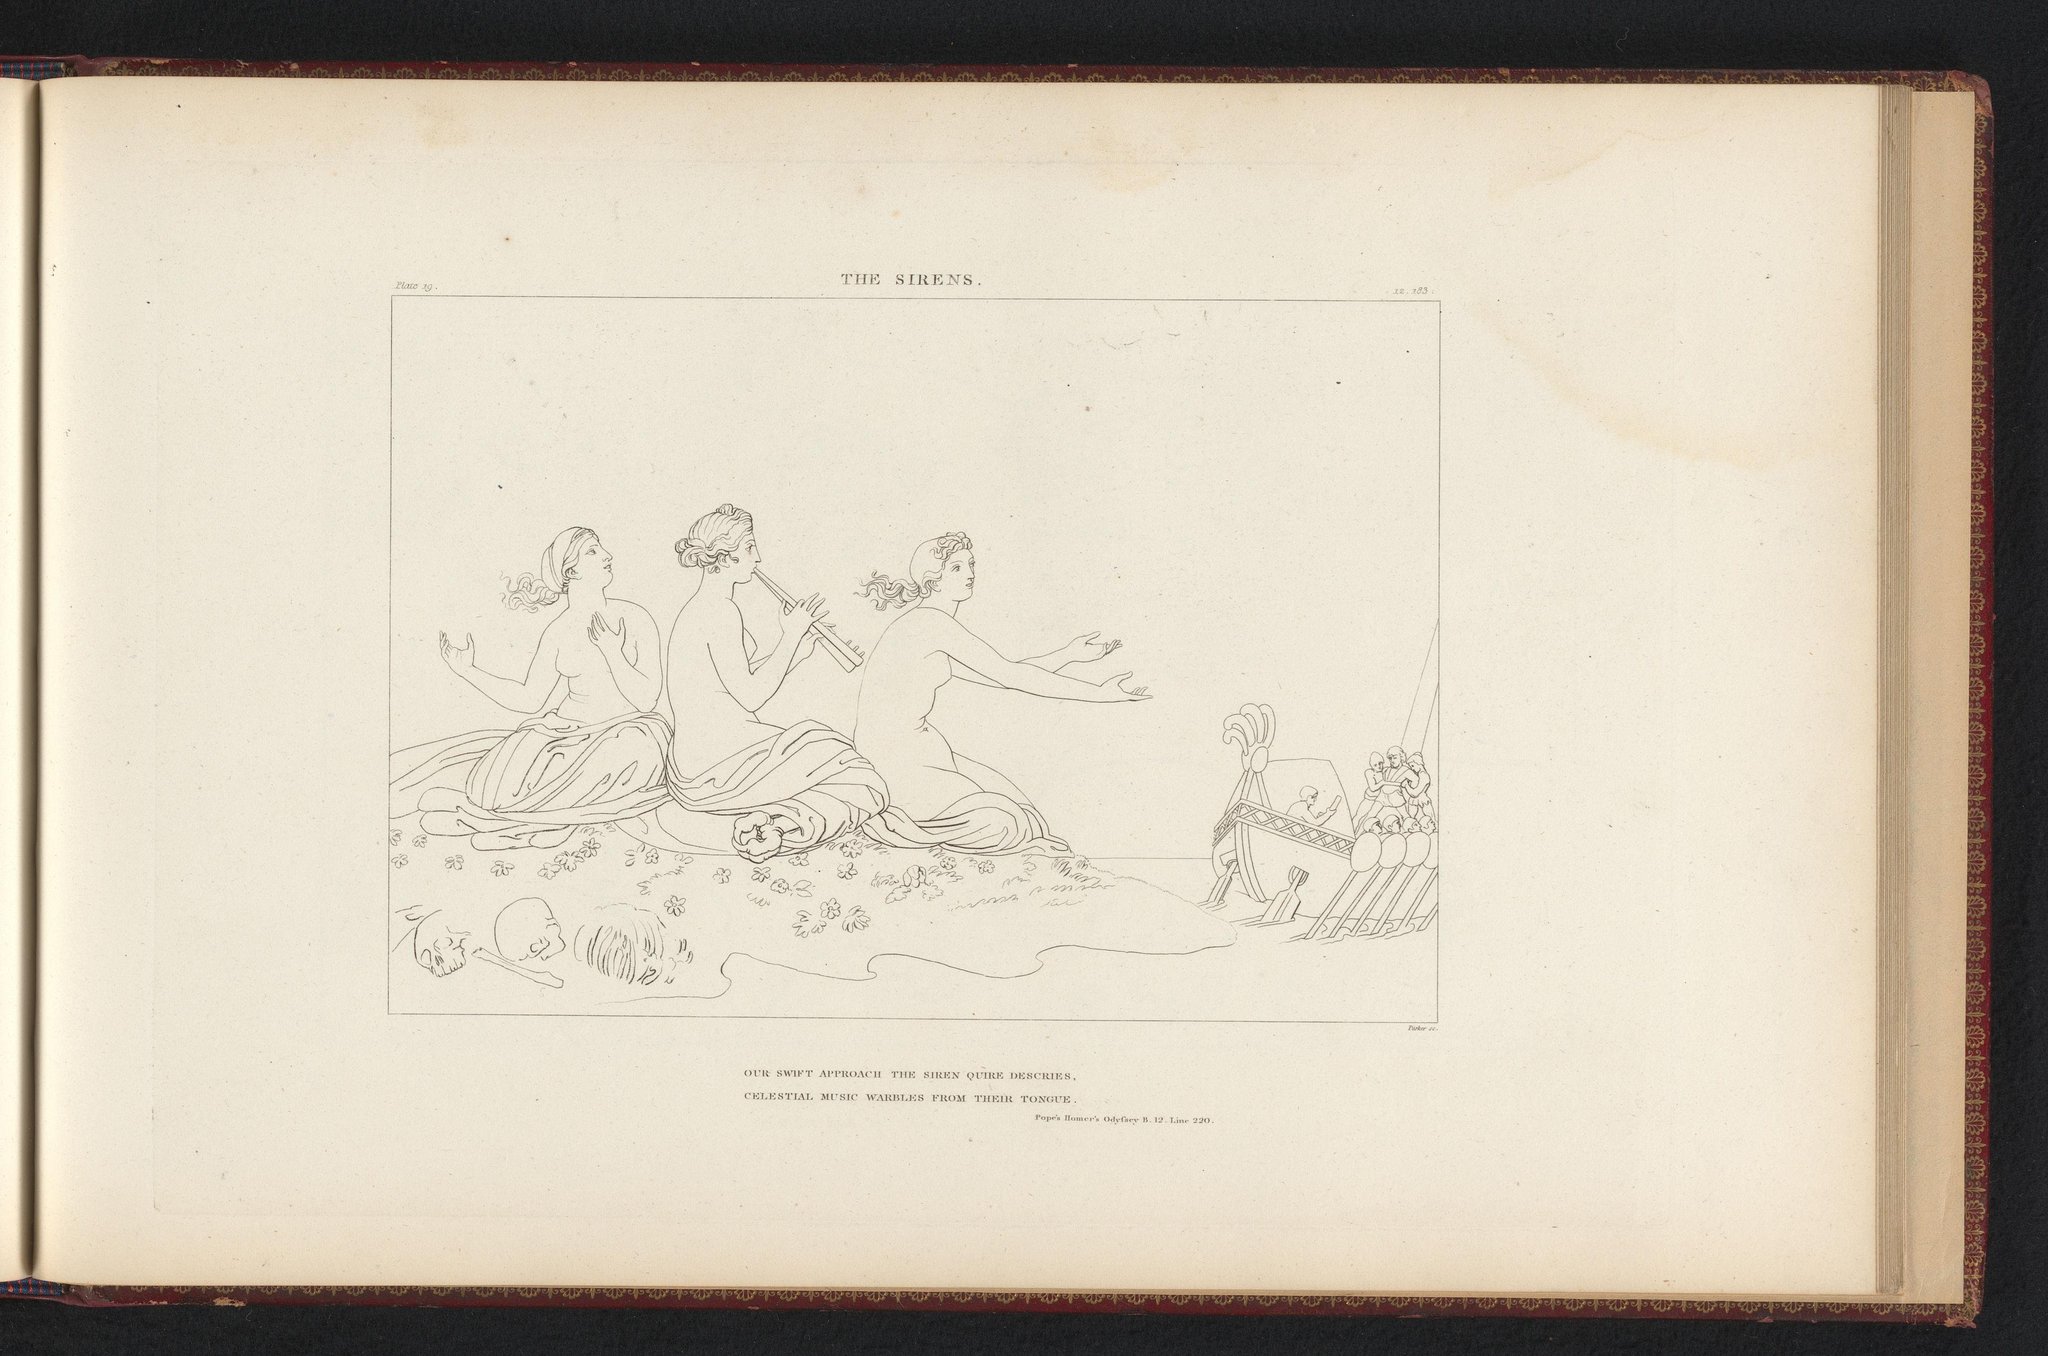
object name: print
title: The Sirens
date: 1805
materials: paper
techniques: etching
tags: ulysses, tied to the mast of his ship, passes the sirens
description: Prent maakt onderdeel uit van een serie met 34 prenten over de Odyssee, geschreven door Homerus.